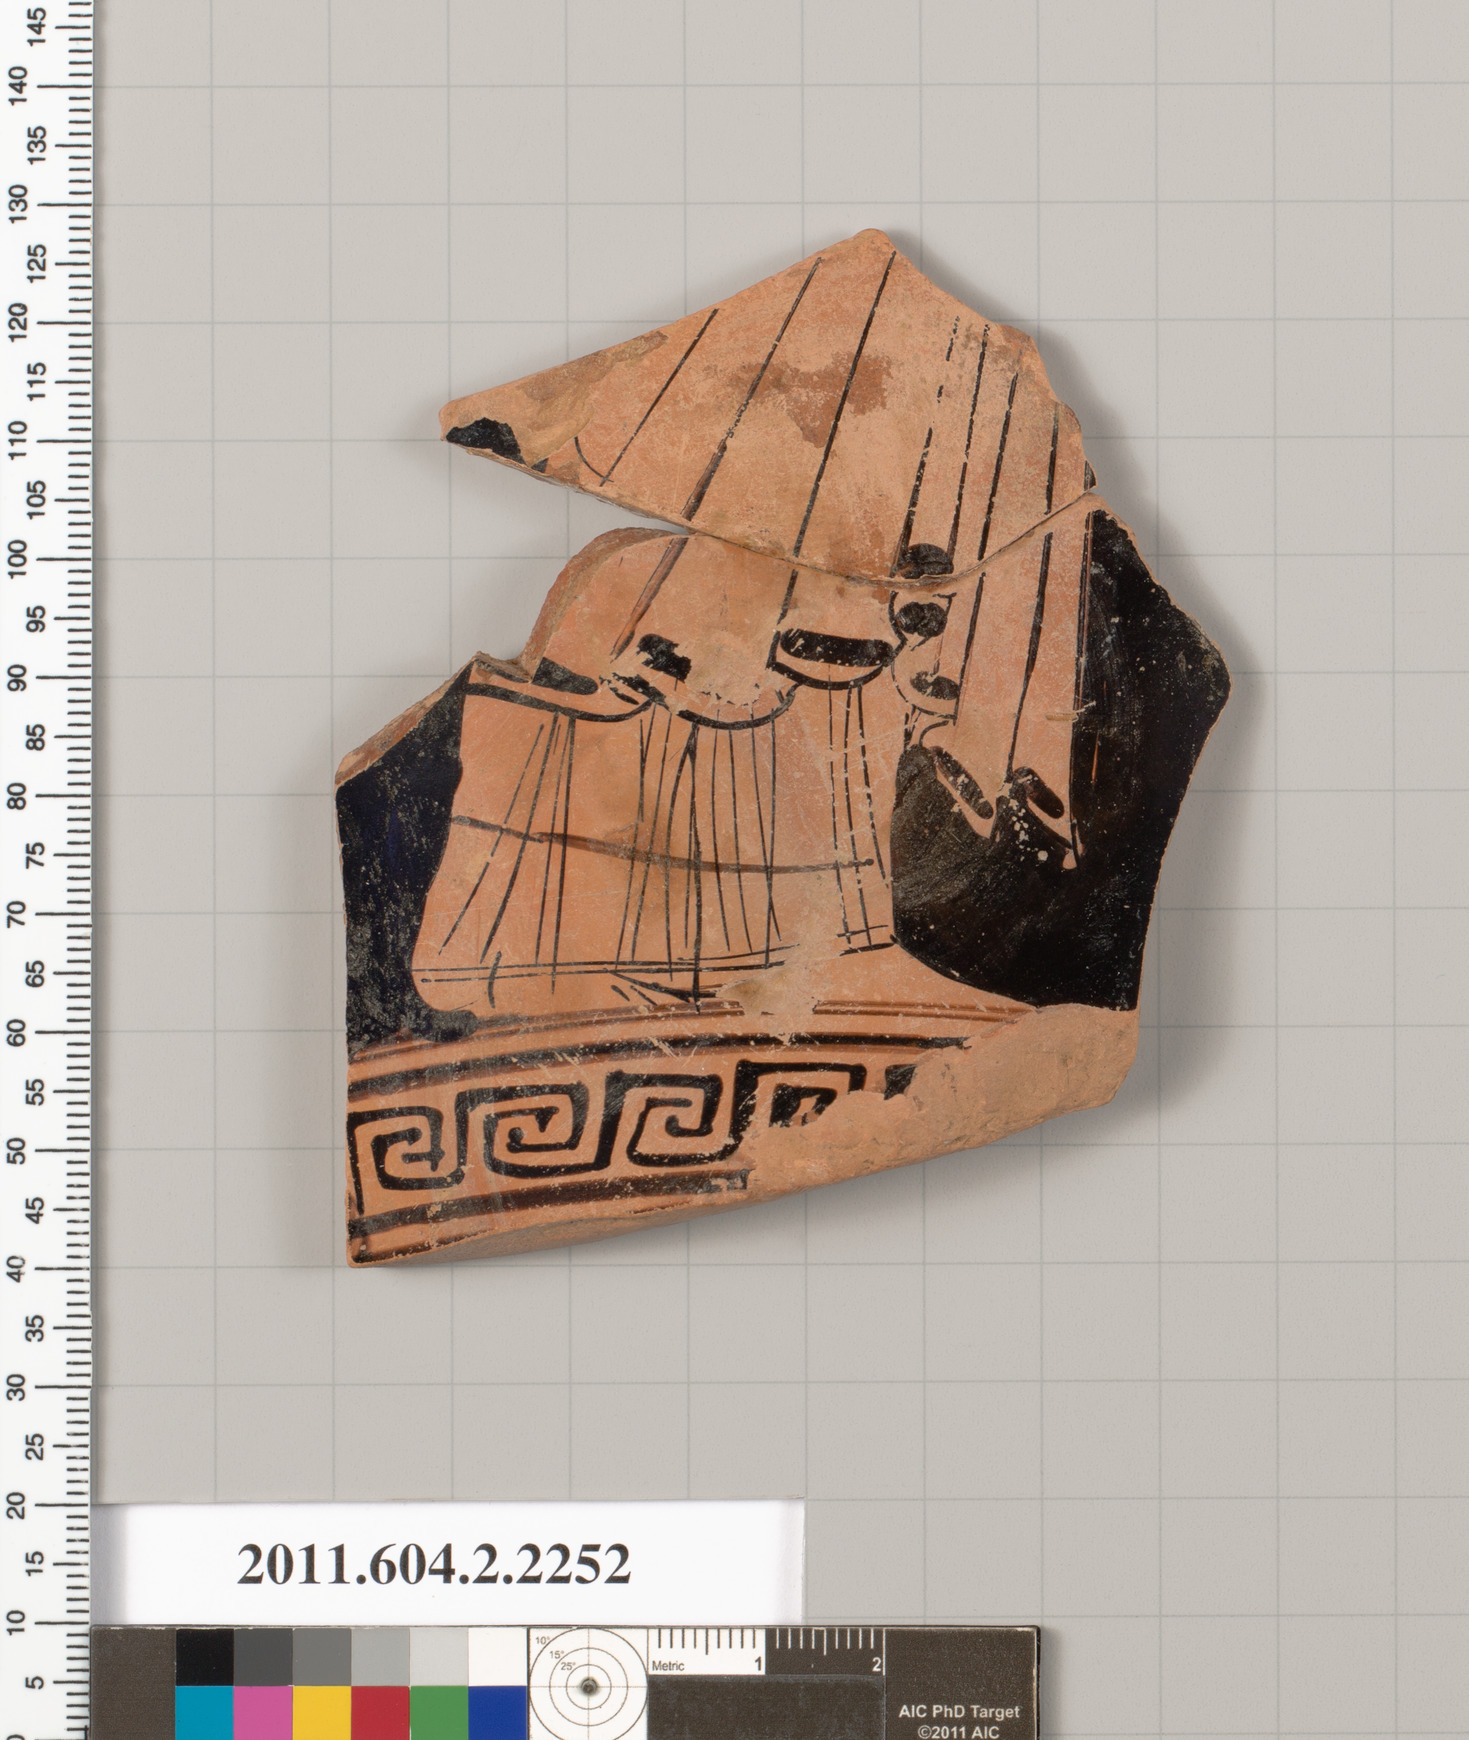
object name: amphora fragment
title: Terracotta fragment of an amphora (jar)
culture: greek, attic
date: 460-440 BCE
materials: terracotta